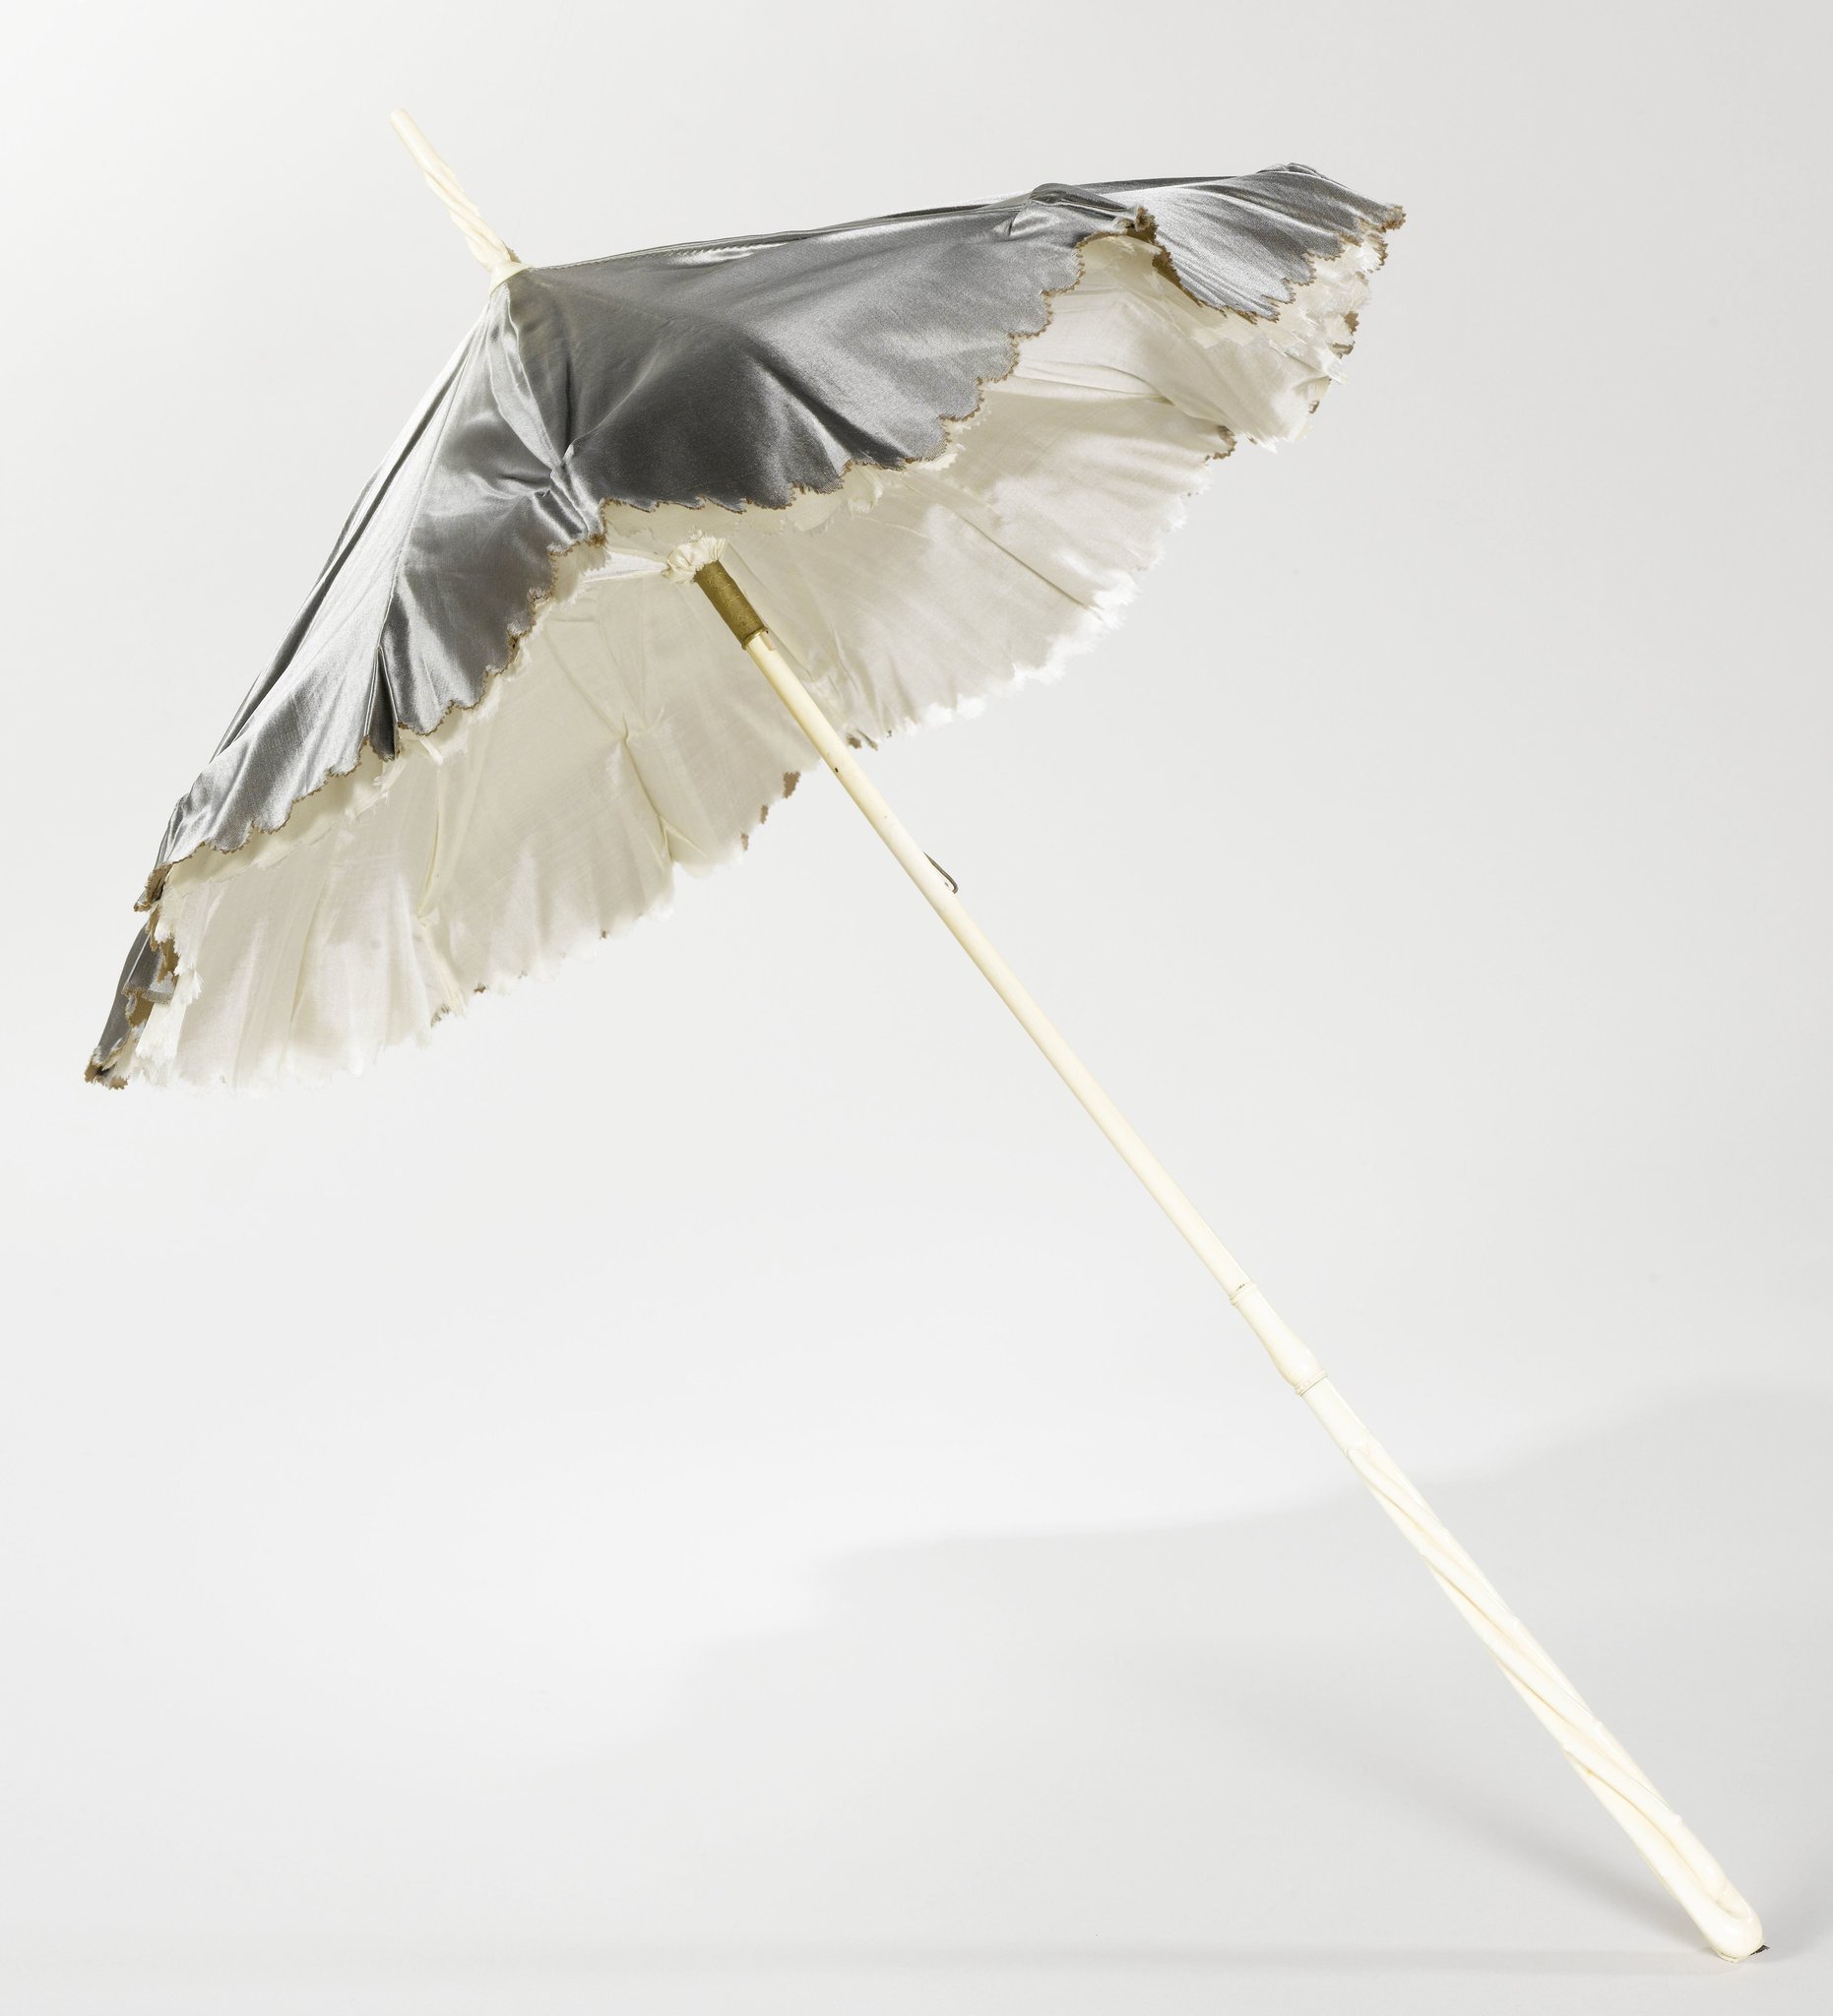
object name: parasol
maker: Anonymous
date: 1890-1900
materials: copper, ivory, metal, silk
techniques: cutting, weave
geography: france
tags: semarang, esther mietje heijman-salomonson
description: The end of this parasol’s stick, the ivory is carved to look like two twisted gnarled twigs. It shows the influence of realism in art (the preference for realistic depictions), which emerged in the second half of the 19th century.